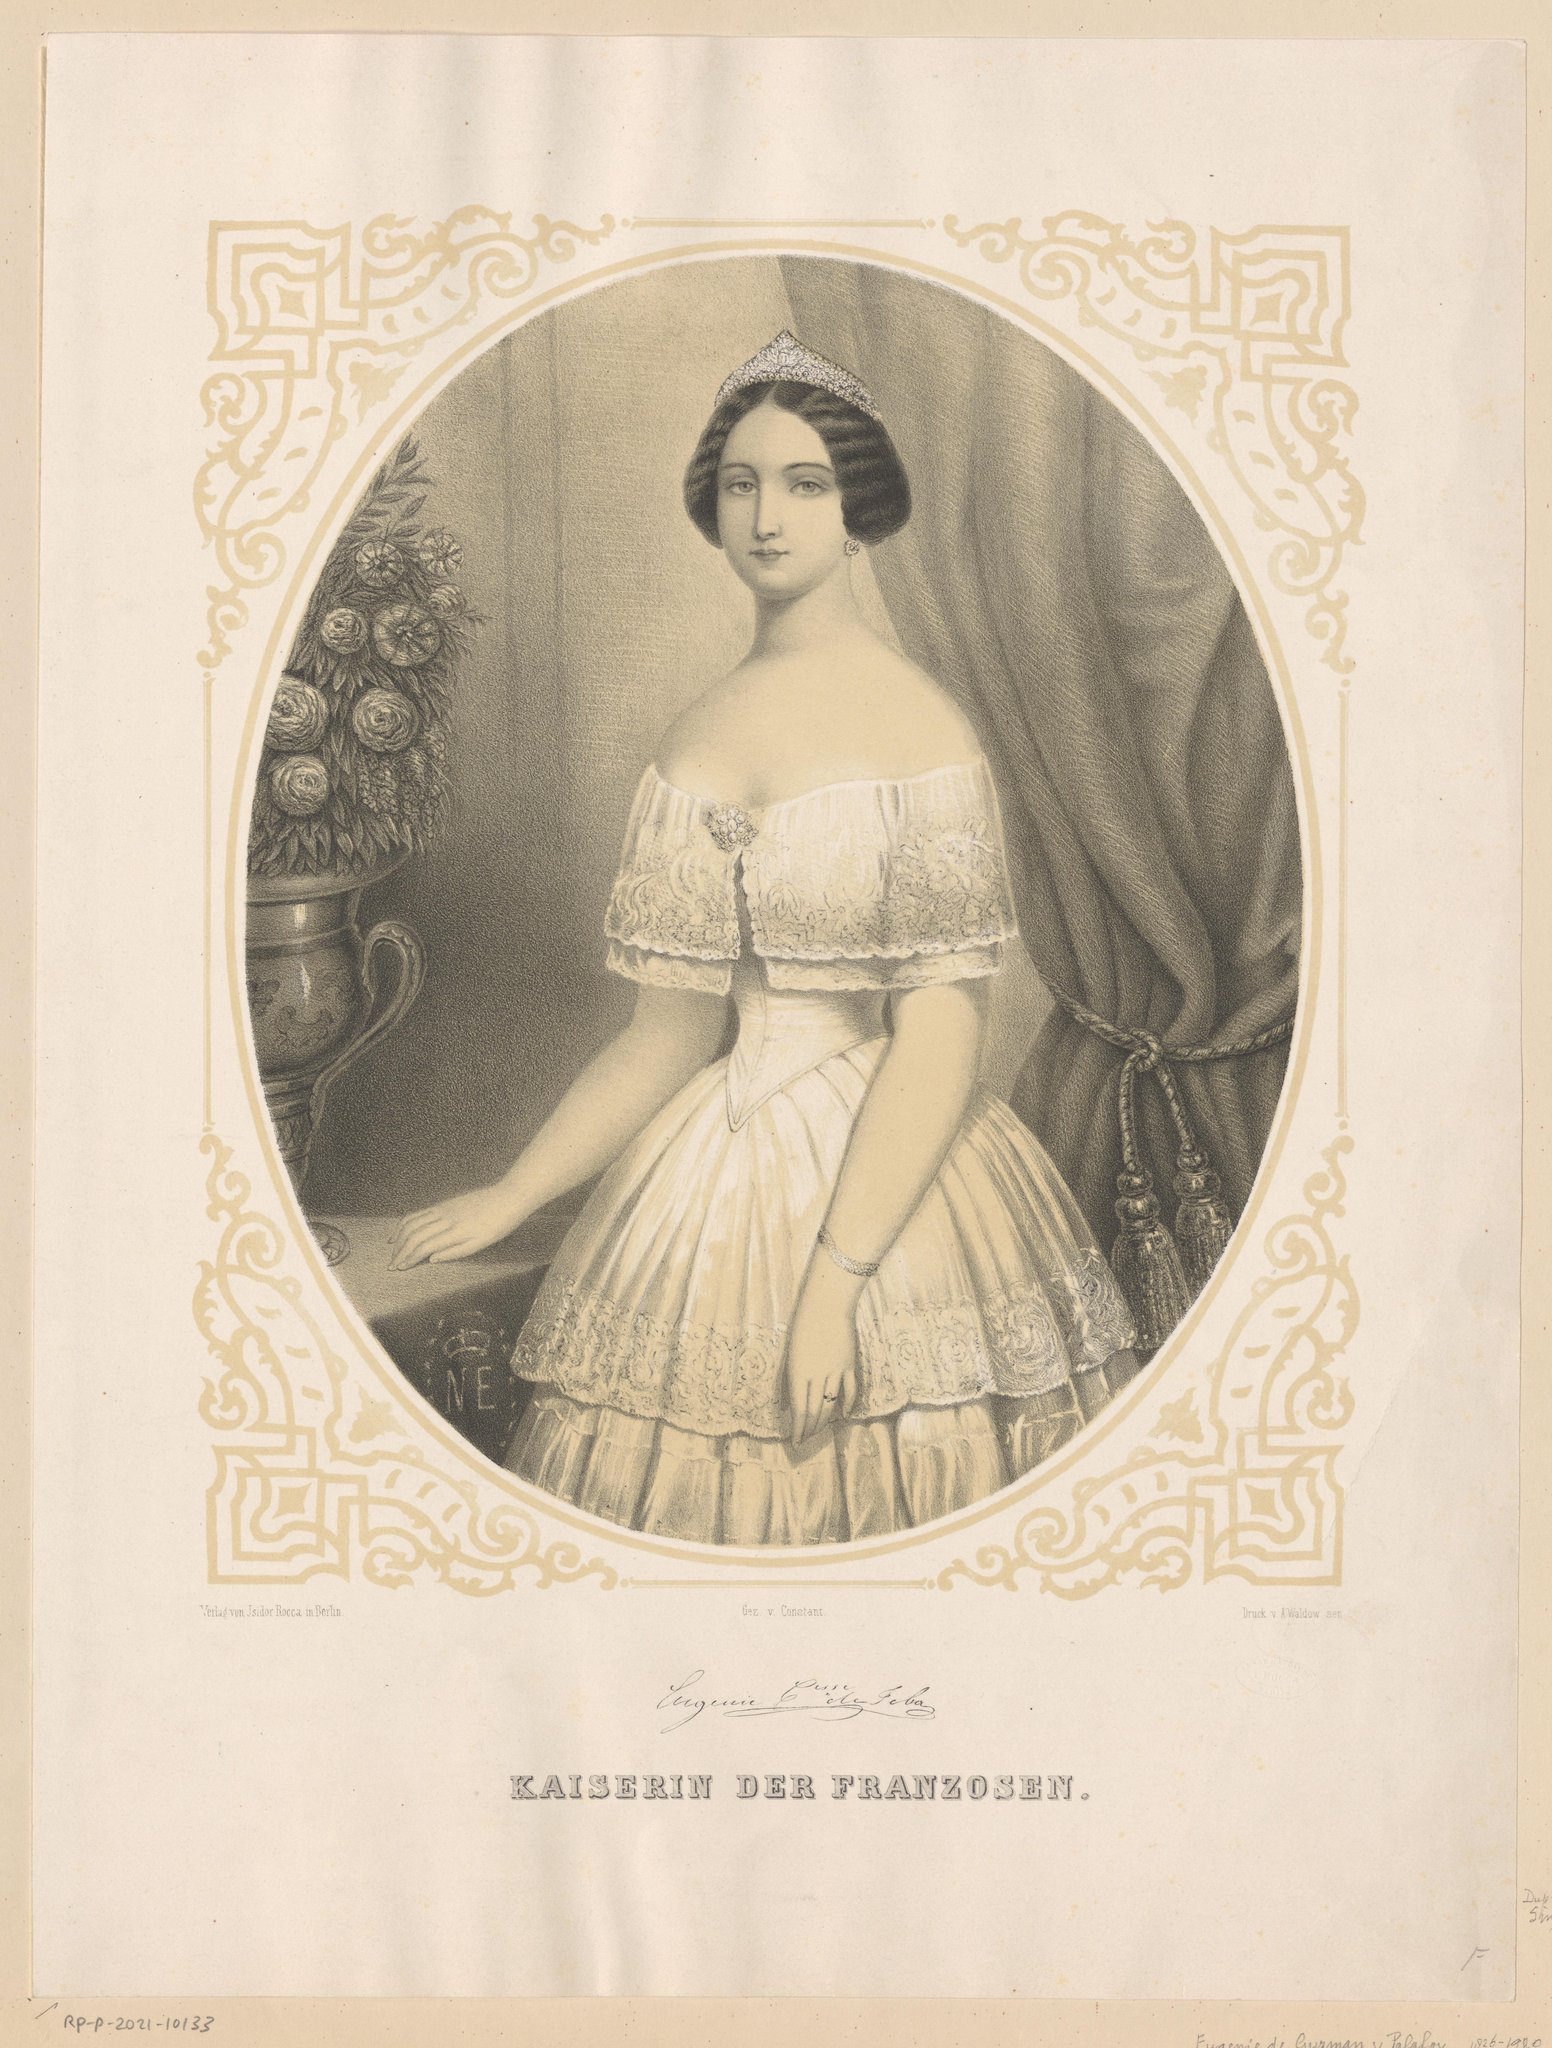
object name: print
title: Portret van Eugénie de Montijo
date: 1853-1871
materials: paper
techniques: tone lithography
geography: berlin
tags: sevilla, historical persons - bb - woman, queen, empress, etc. (wife of a ruler)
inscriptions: check stamp: ‘Kunst Handlung I. Rocca Berlin’, collector's mark: Lugt 2228